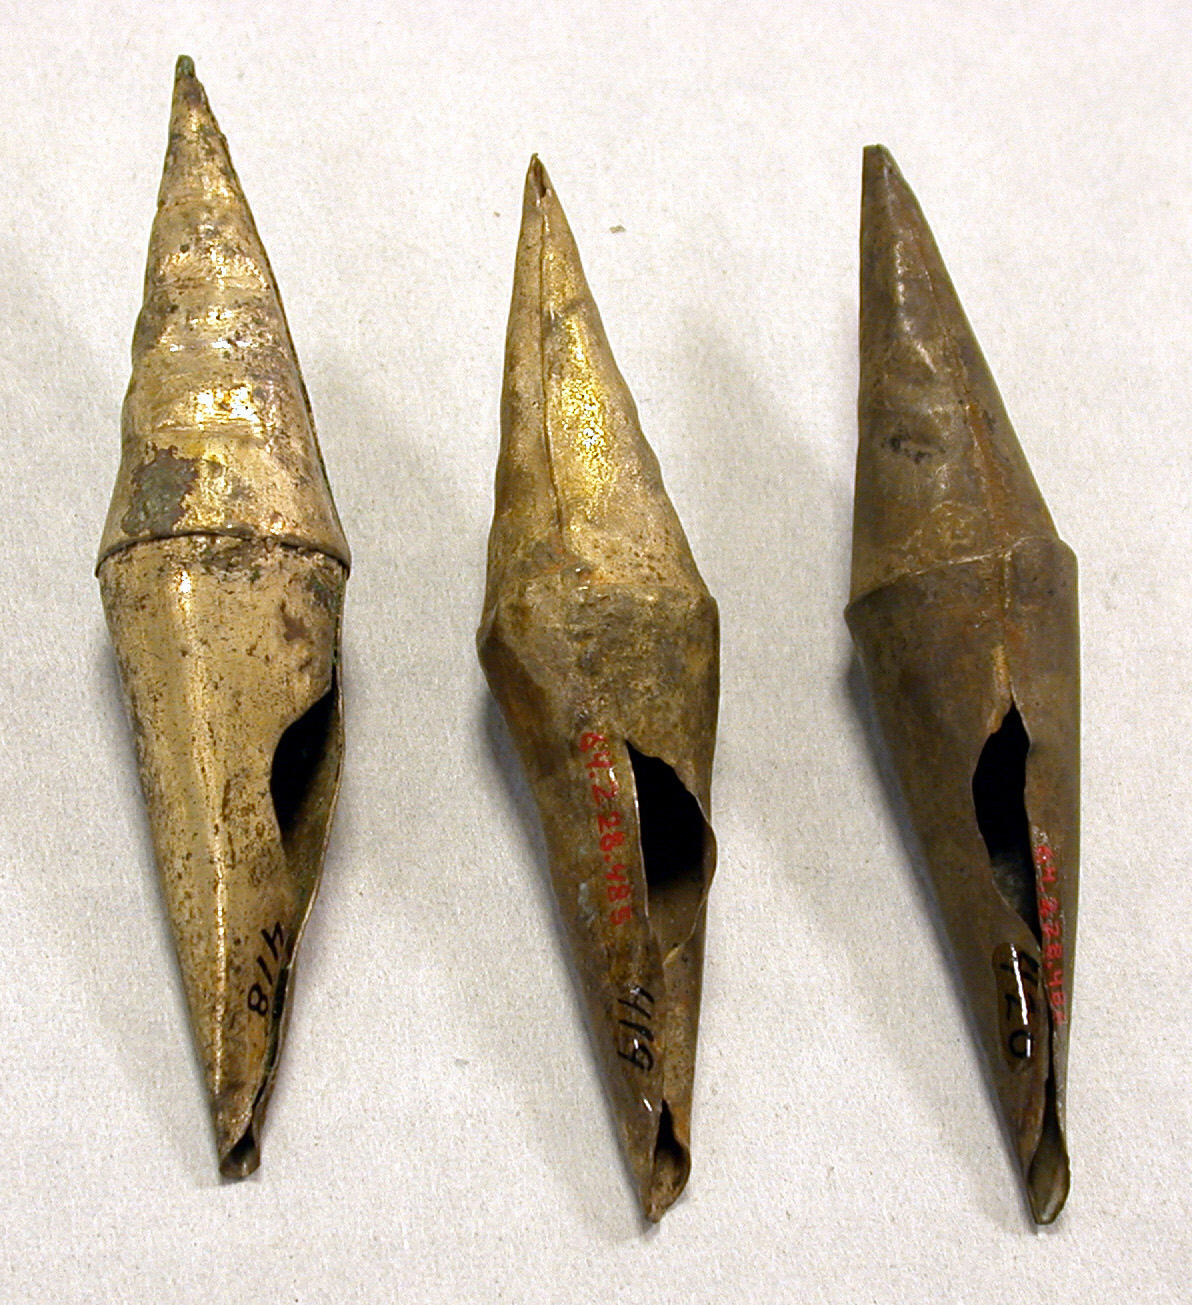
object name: ornament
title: Hammered Silver Cone Ornament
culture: peruvian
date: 701-1566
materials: gilt, silver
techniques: hammering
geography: peru